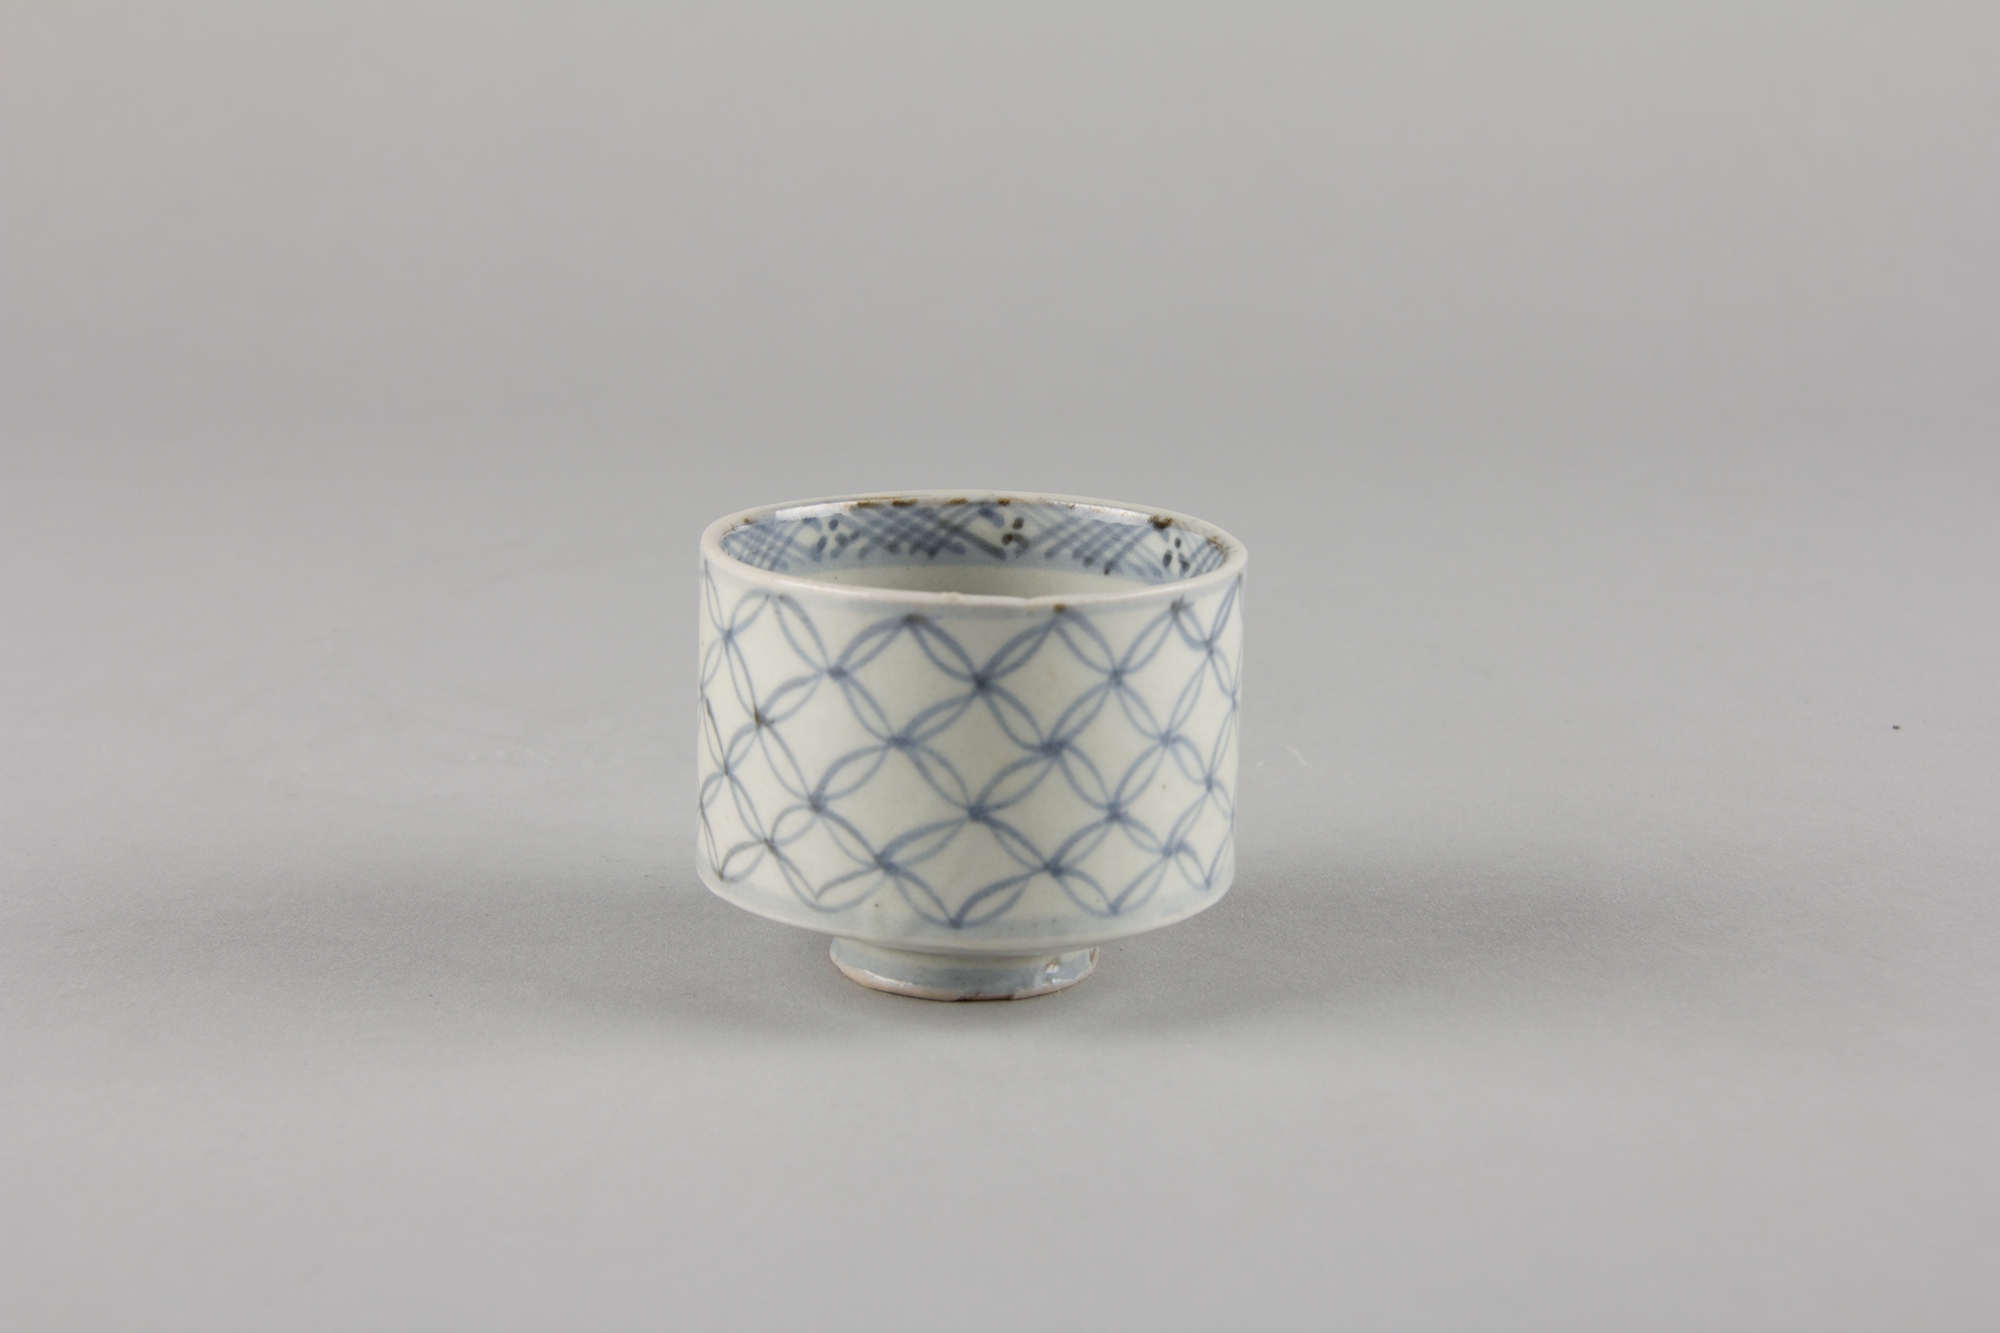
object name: soba cup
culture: japanese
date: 1701-1750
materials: porcelain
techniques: underglaze